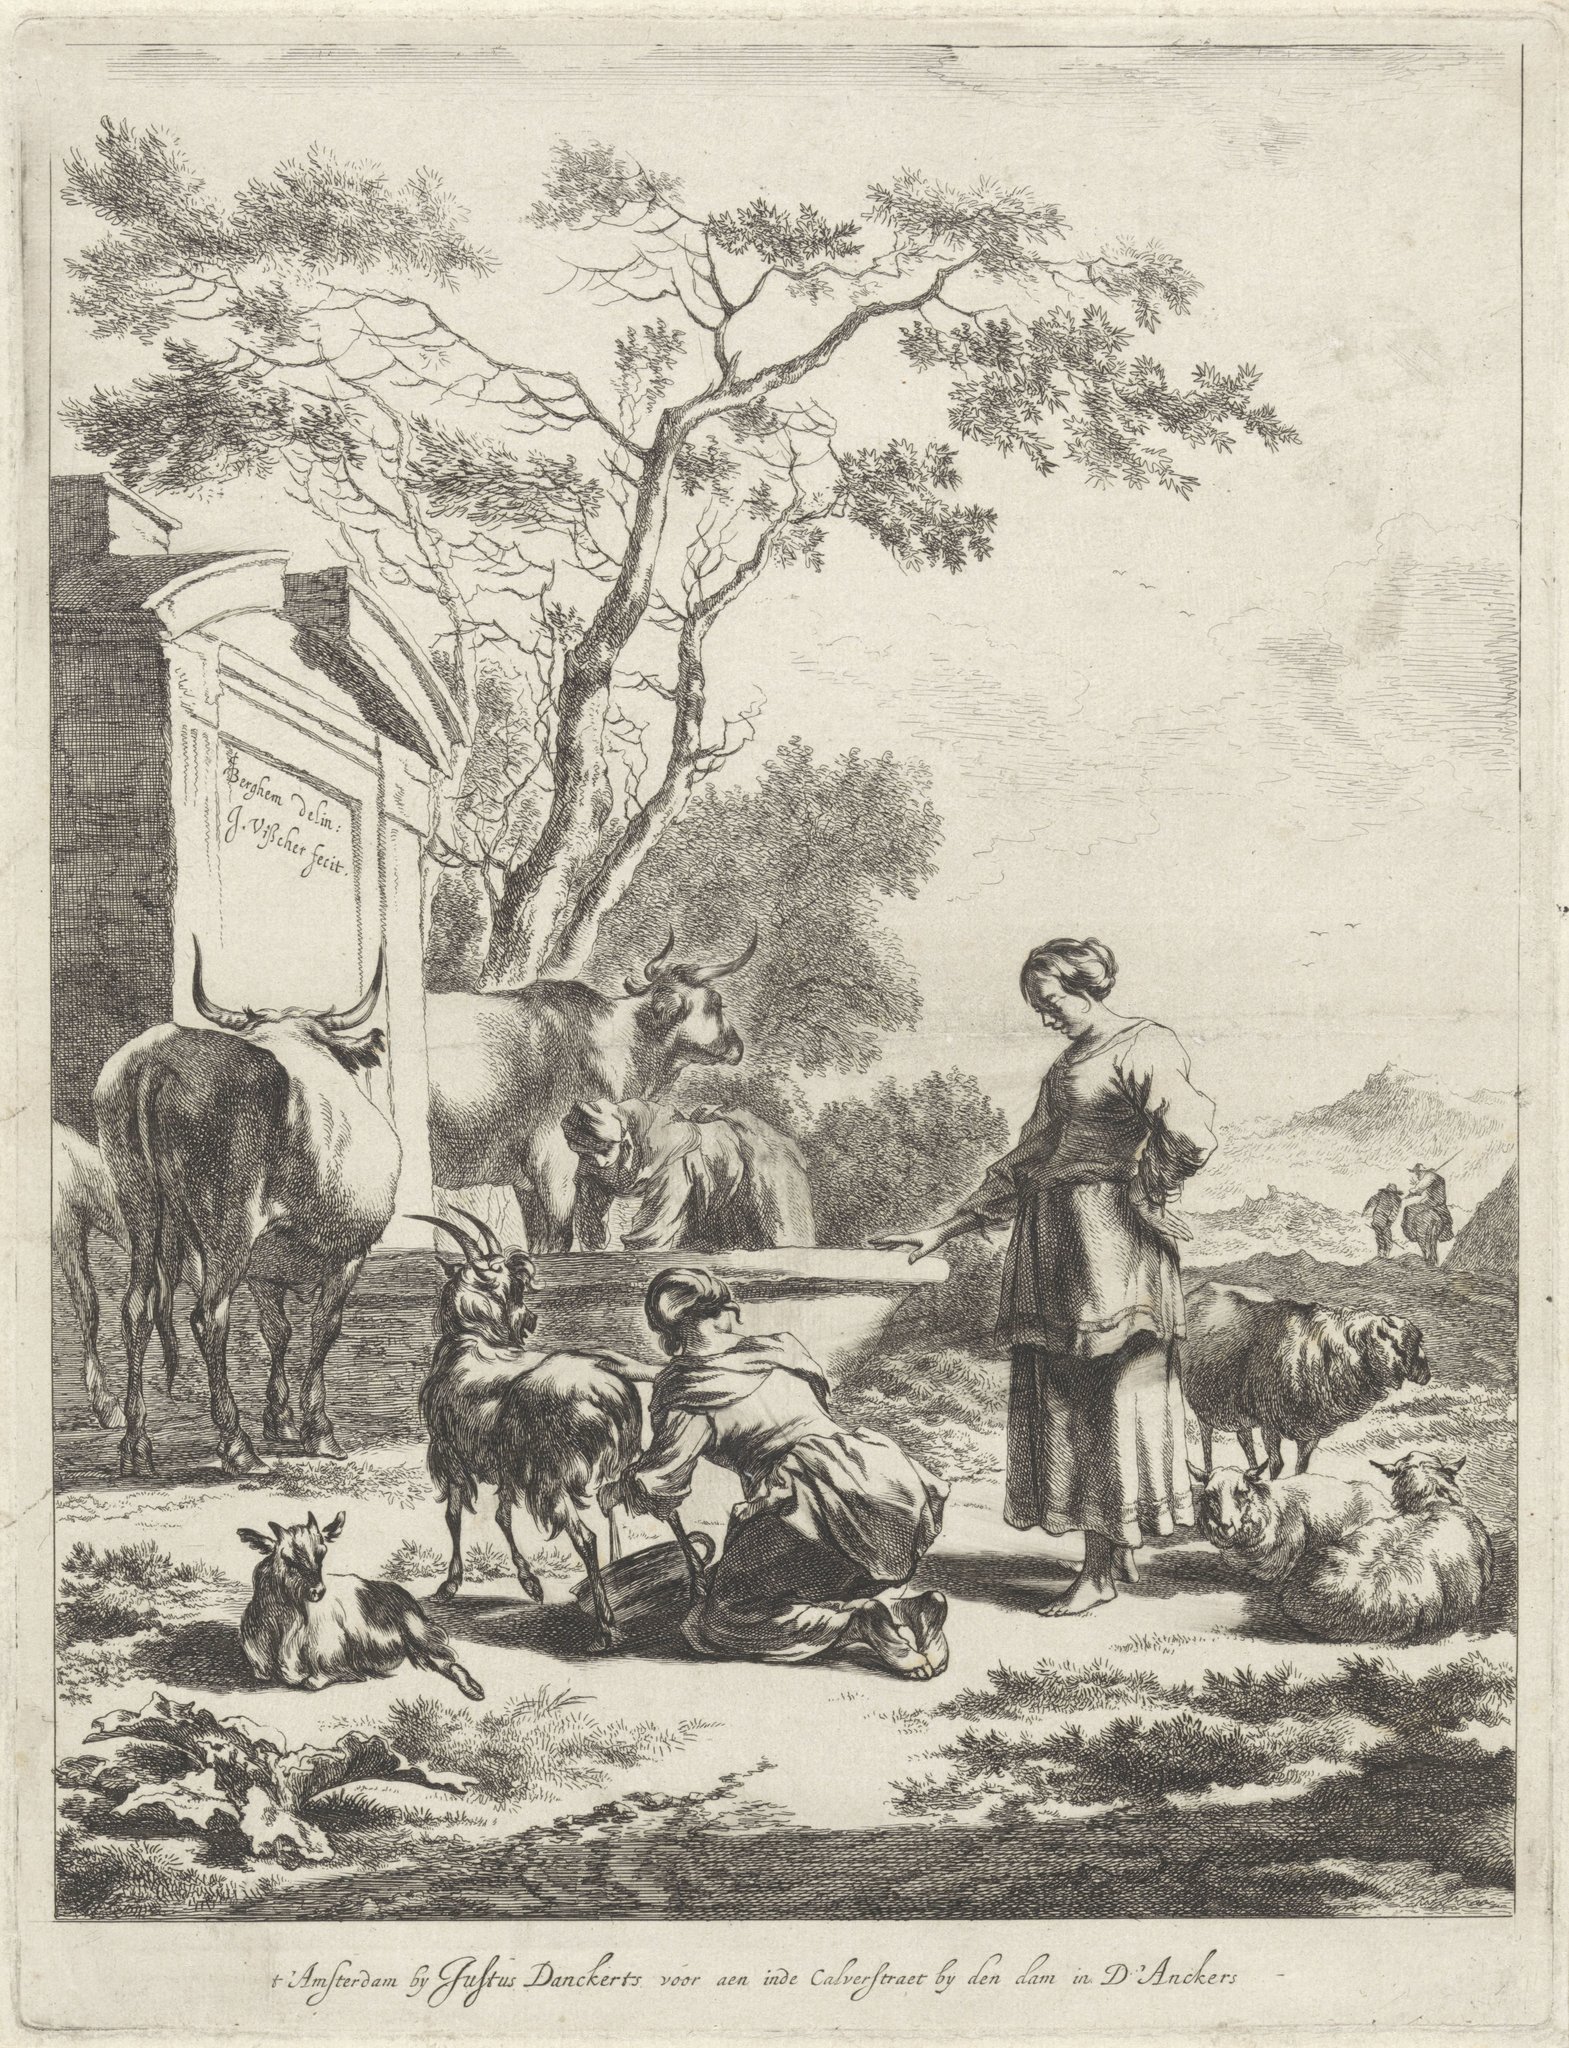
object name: titelprent, frontispice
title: Titelprent voor een reeks pastorale landschappen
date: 1650-1701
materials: paper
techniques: engraving, etching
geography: amsterdam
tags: cow, herding, herdsman, herdswoman, shepherd, shepherdess, cowherd, etc., goat, milking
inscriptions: collector's mark: Lugt 240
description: Titelprent voor een reeks pastorale landschappen, met drie herderinnen bij een bron. De voorste melkt een geit, een ander staat toe te kijken en de derde haalt water uit de put. Bij de bron staan koeien en geiten.